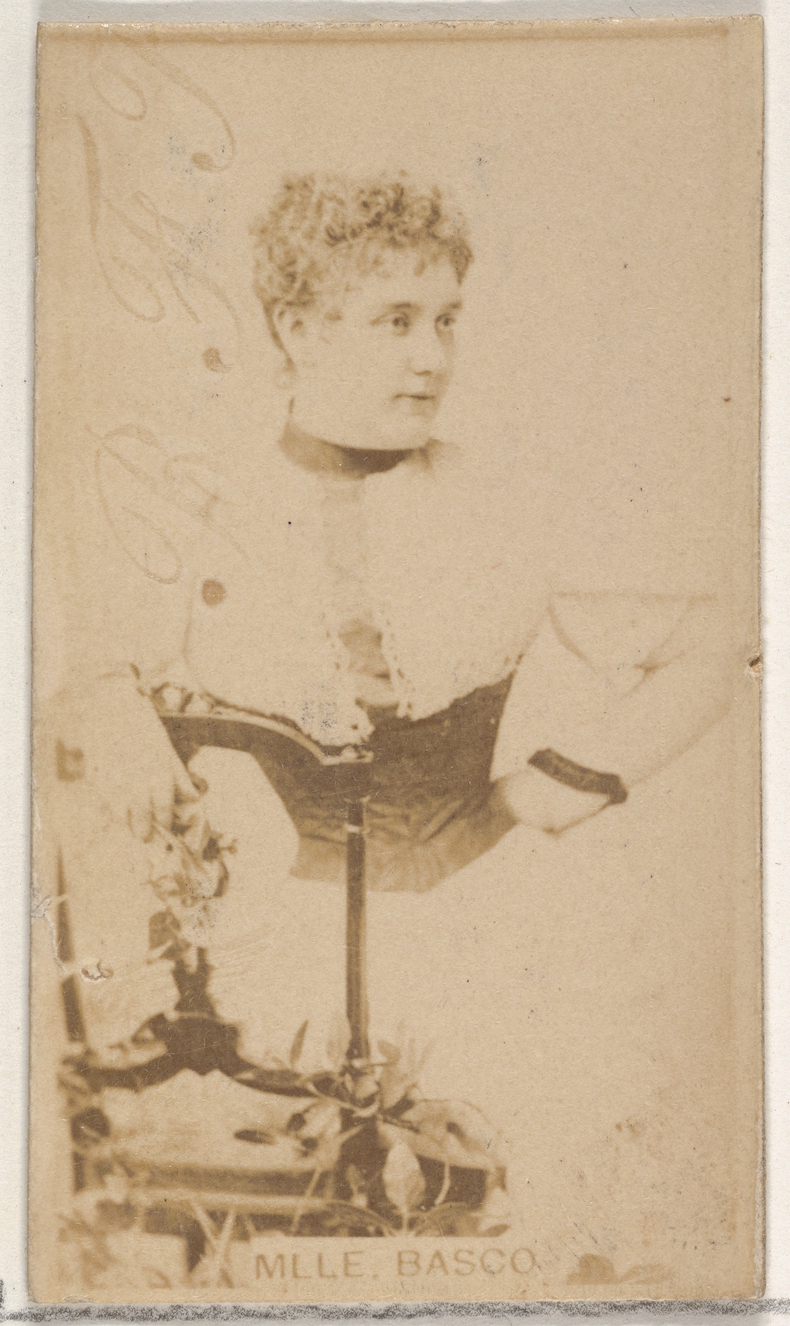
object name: photograph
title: Mlle. Basco, from the Actors and Actresses series (N45, Type 8) for Virginia Brights Cigarettes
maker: allen & ginter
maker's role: publisher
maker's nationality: american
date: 1888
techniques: albumen silver print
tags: portraits,women,actresses